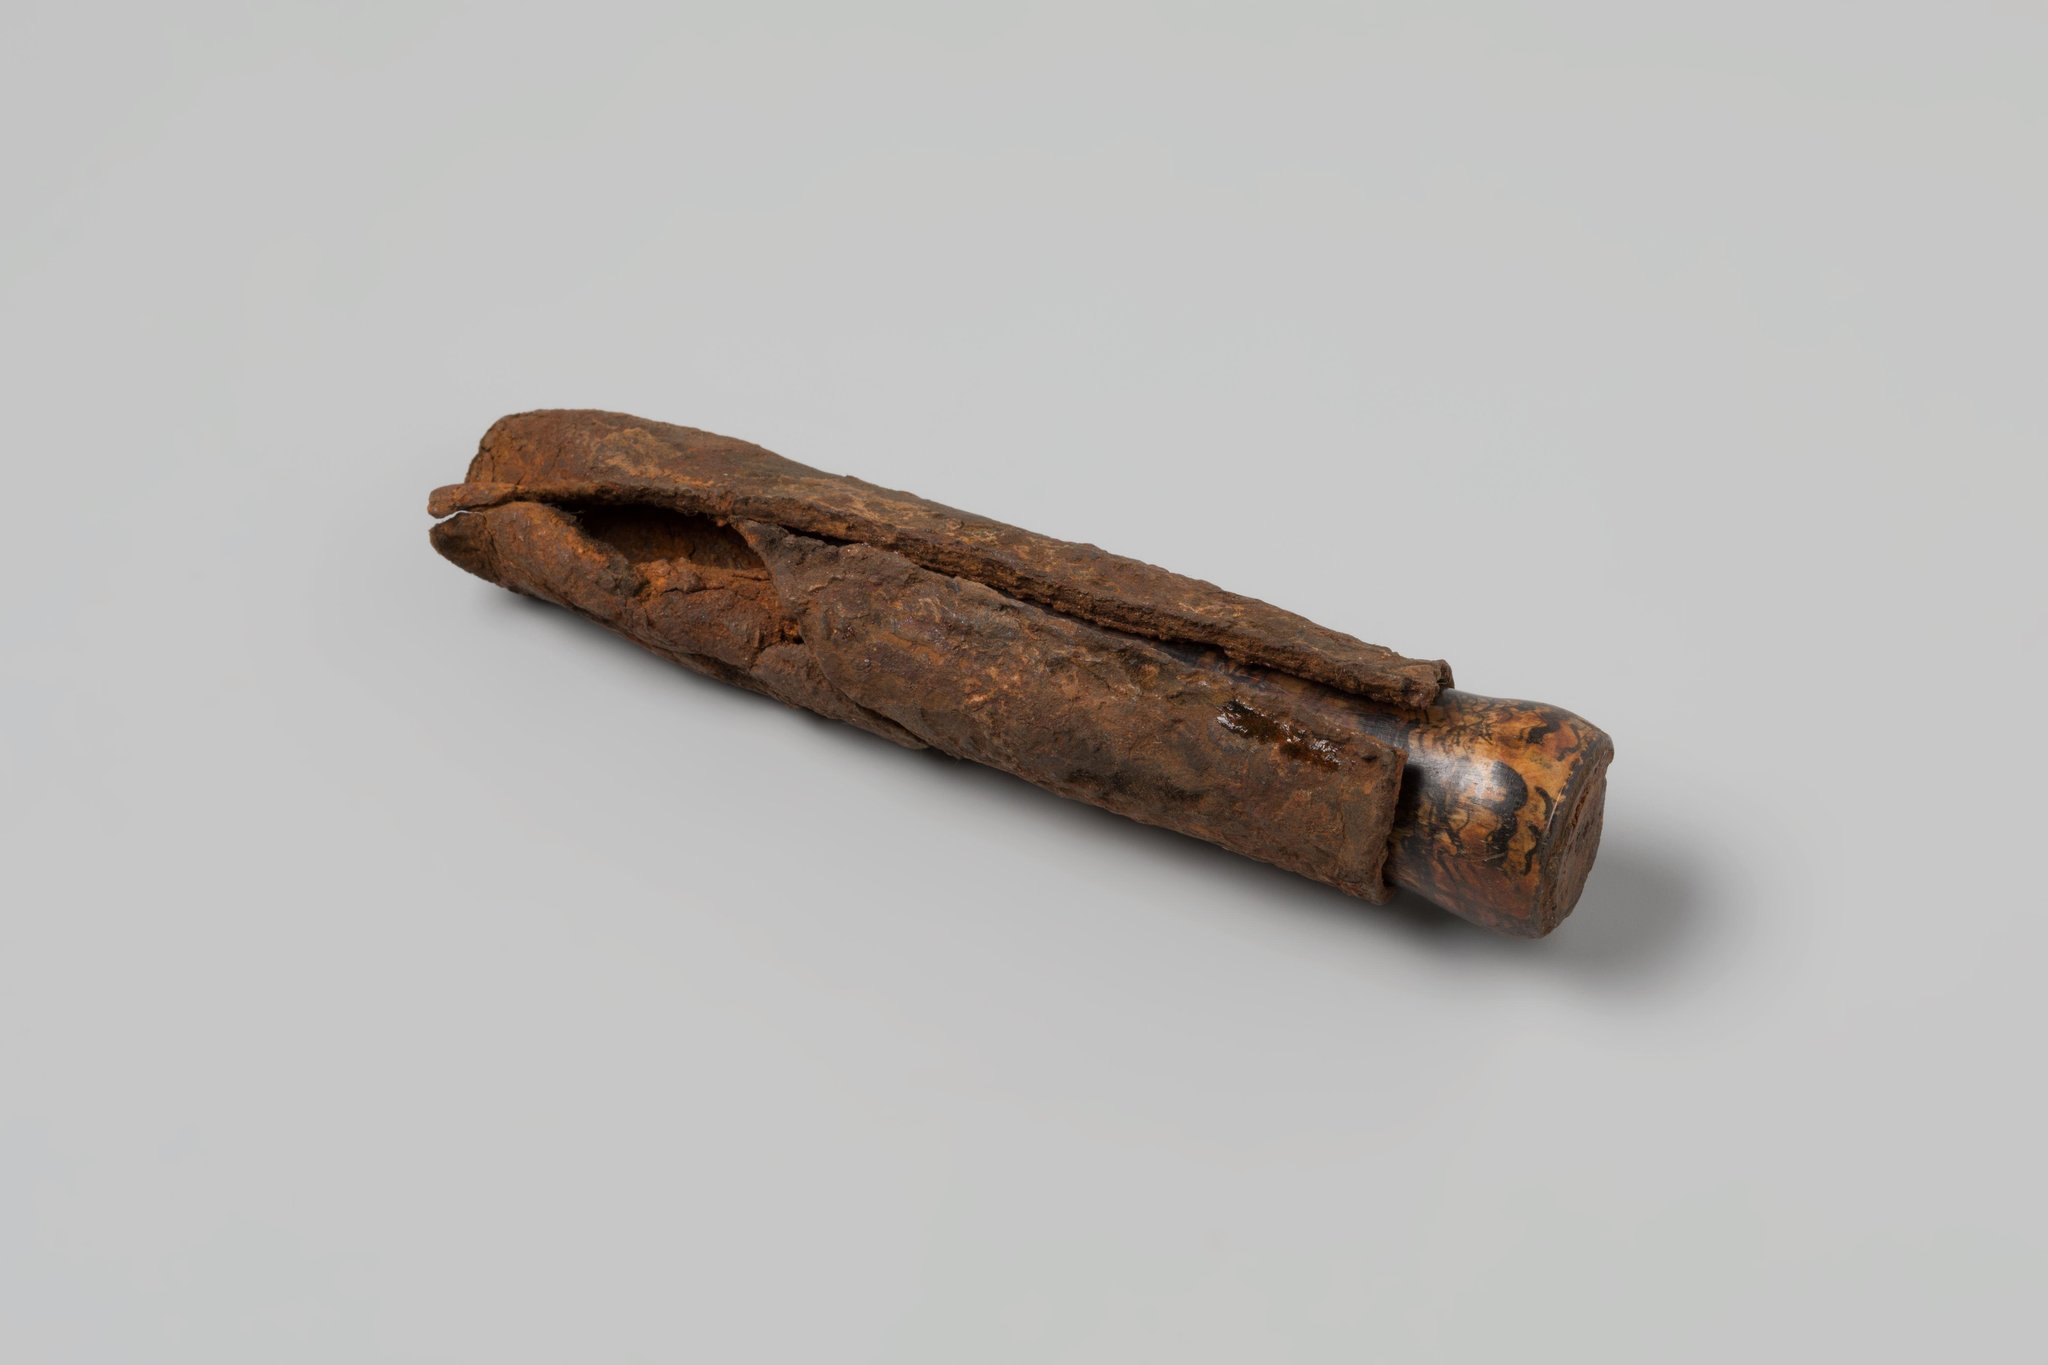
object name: knife handle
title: Messenheft in schede uit het wrak van de Oost-Indiëvaarder Hollandia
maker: Anonymous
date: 1700-1743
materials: bone, leather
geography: netherlands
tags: verenigde oostindische compagnie, hollandia (schip), annet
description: Knife, handle in scabbard, cylindrical: tapering; handle, plain, flat upper end with partial imprint of original mounting (nailed coin?), illegible: ferrule, broken off, square tang cavity, remains of stuffing: fragm of (le) scabbard, oval in section, longitudinal seam, lower end broken off.